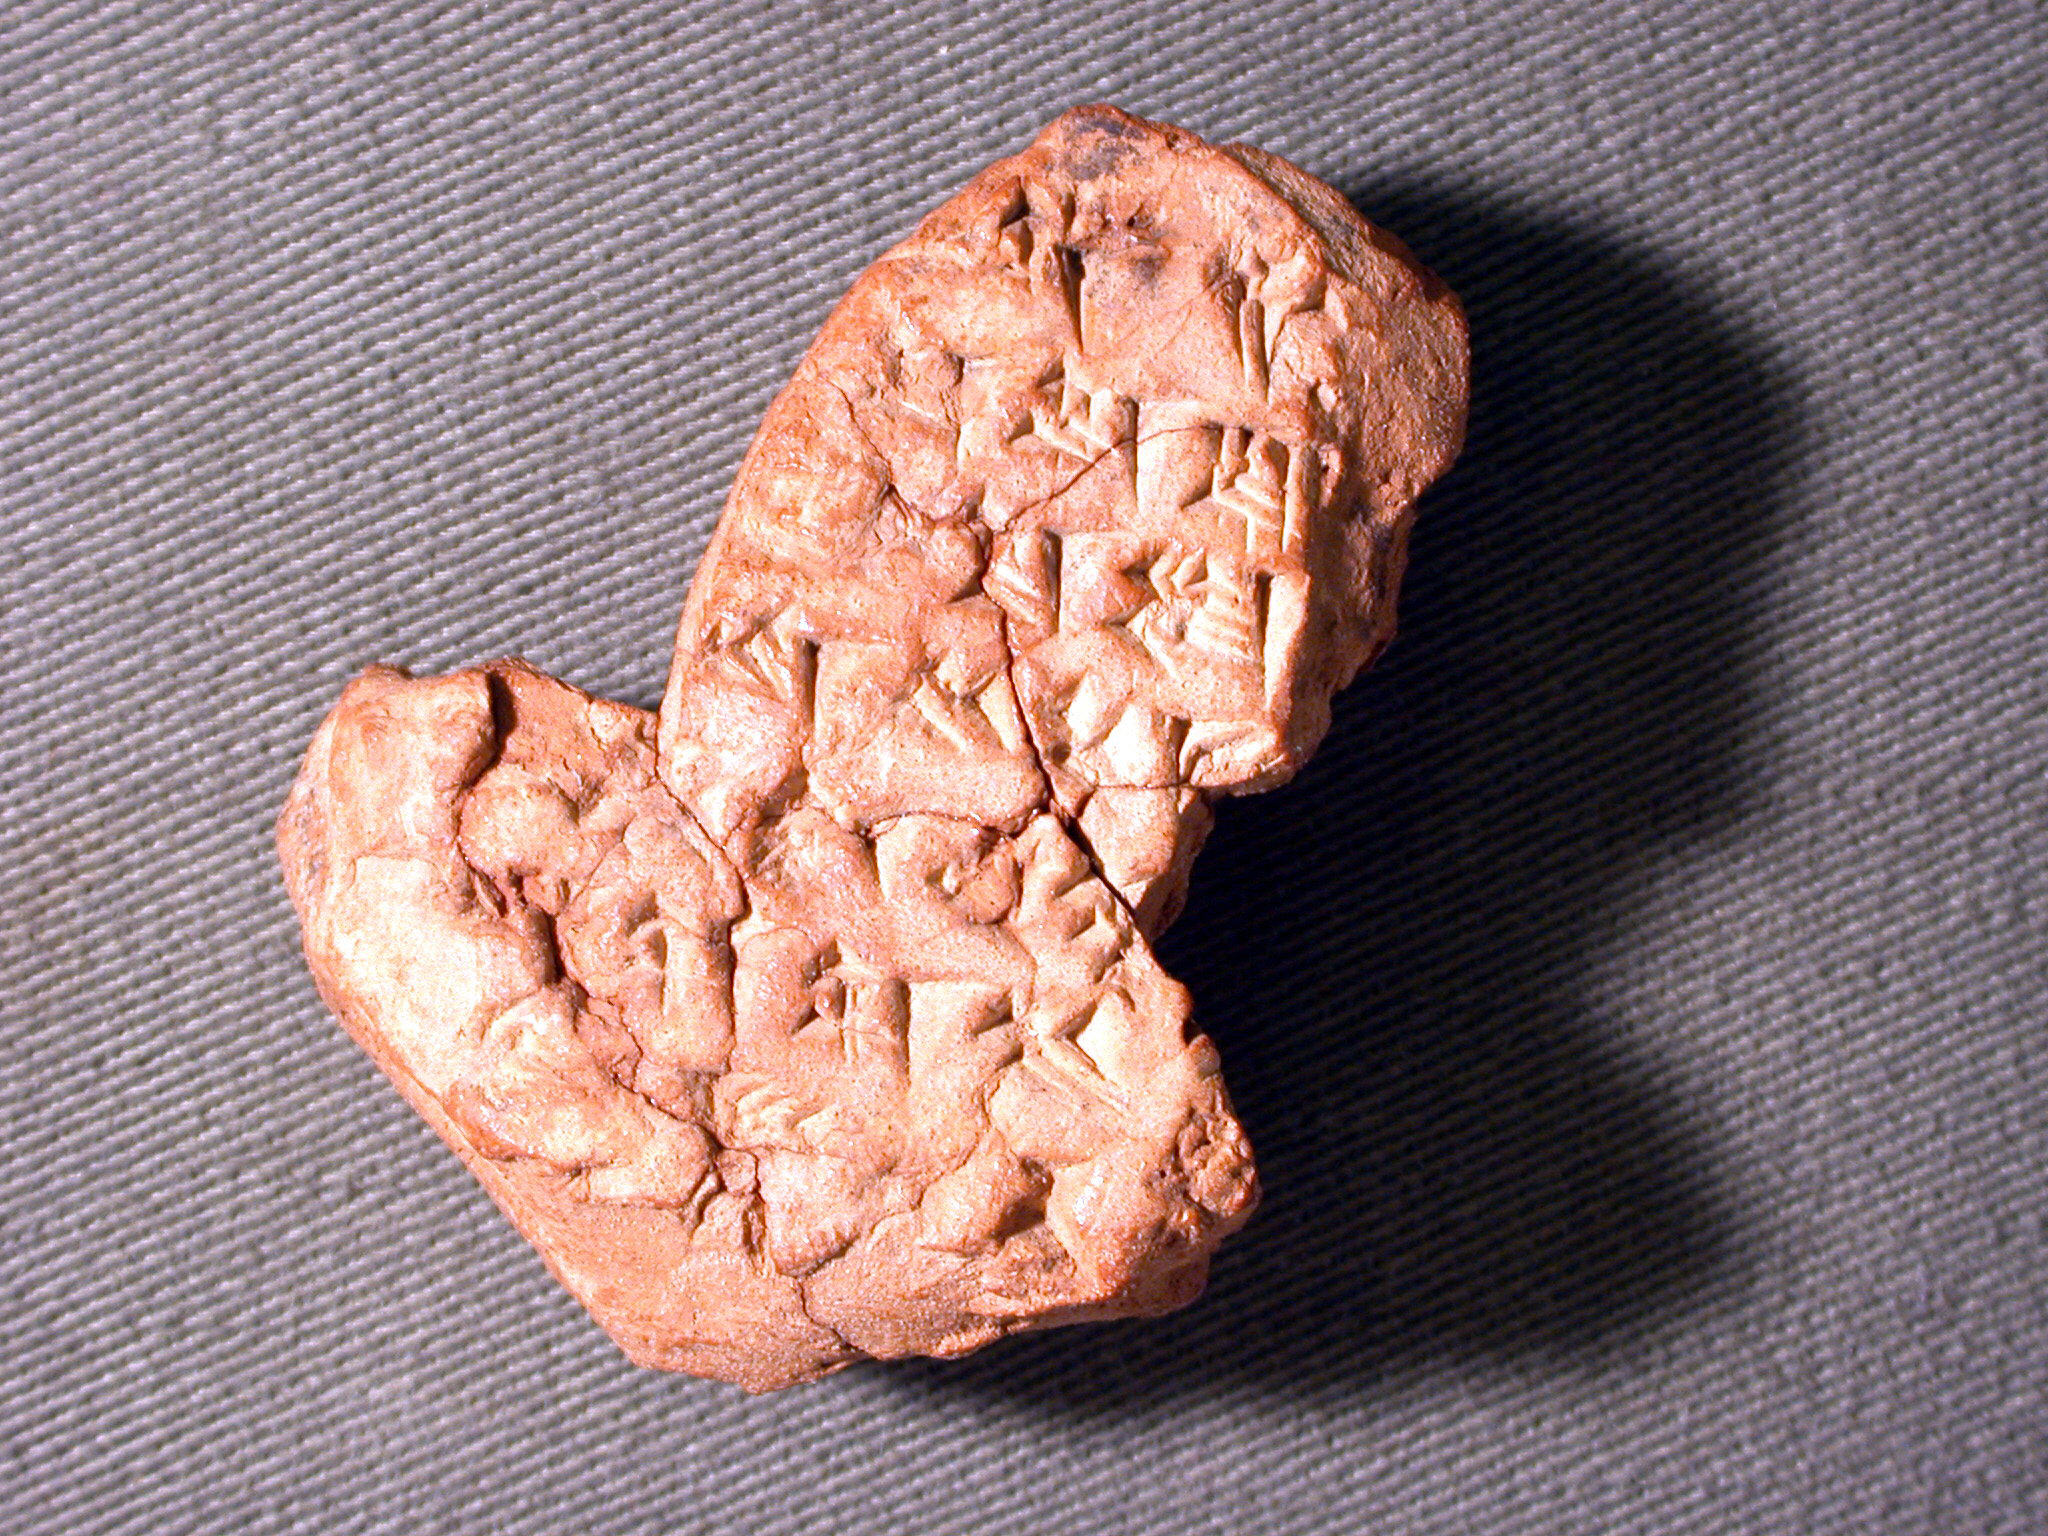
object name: cuneiform tablet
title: Cuneiform tablet: fragment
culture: achaemenid or babylonian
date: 700-301 BCE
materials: clay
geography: mesopotamia